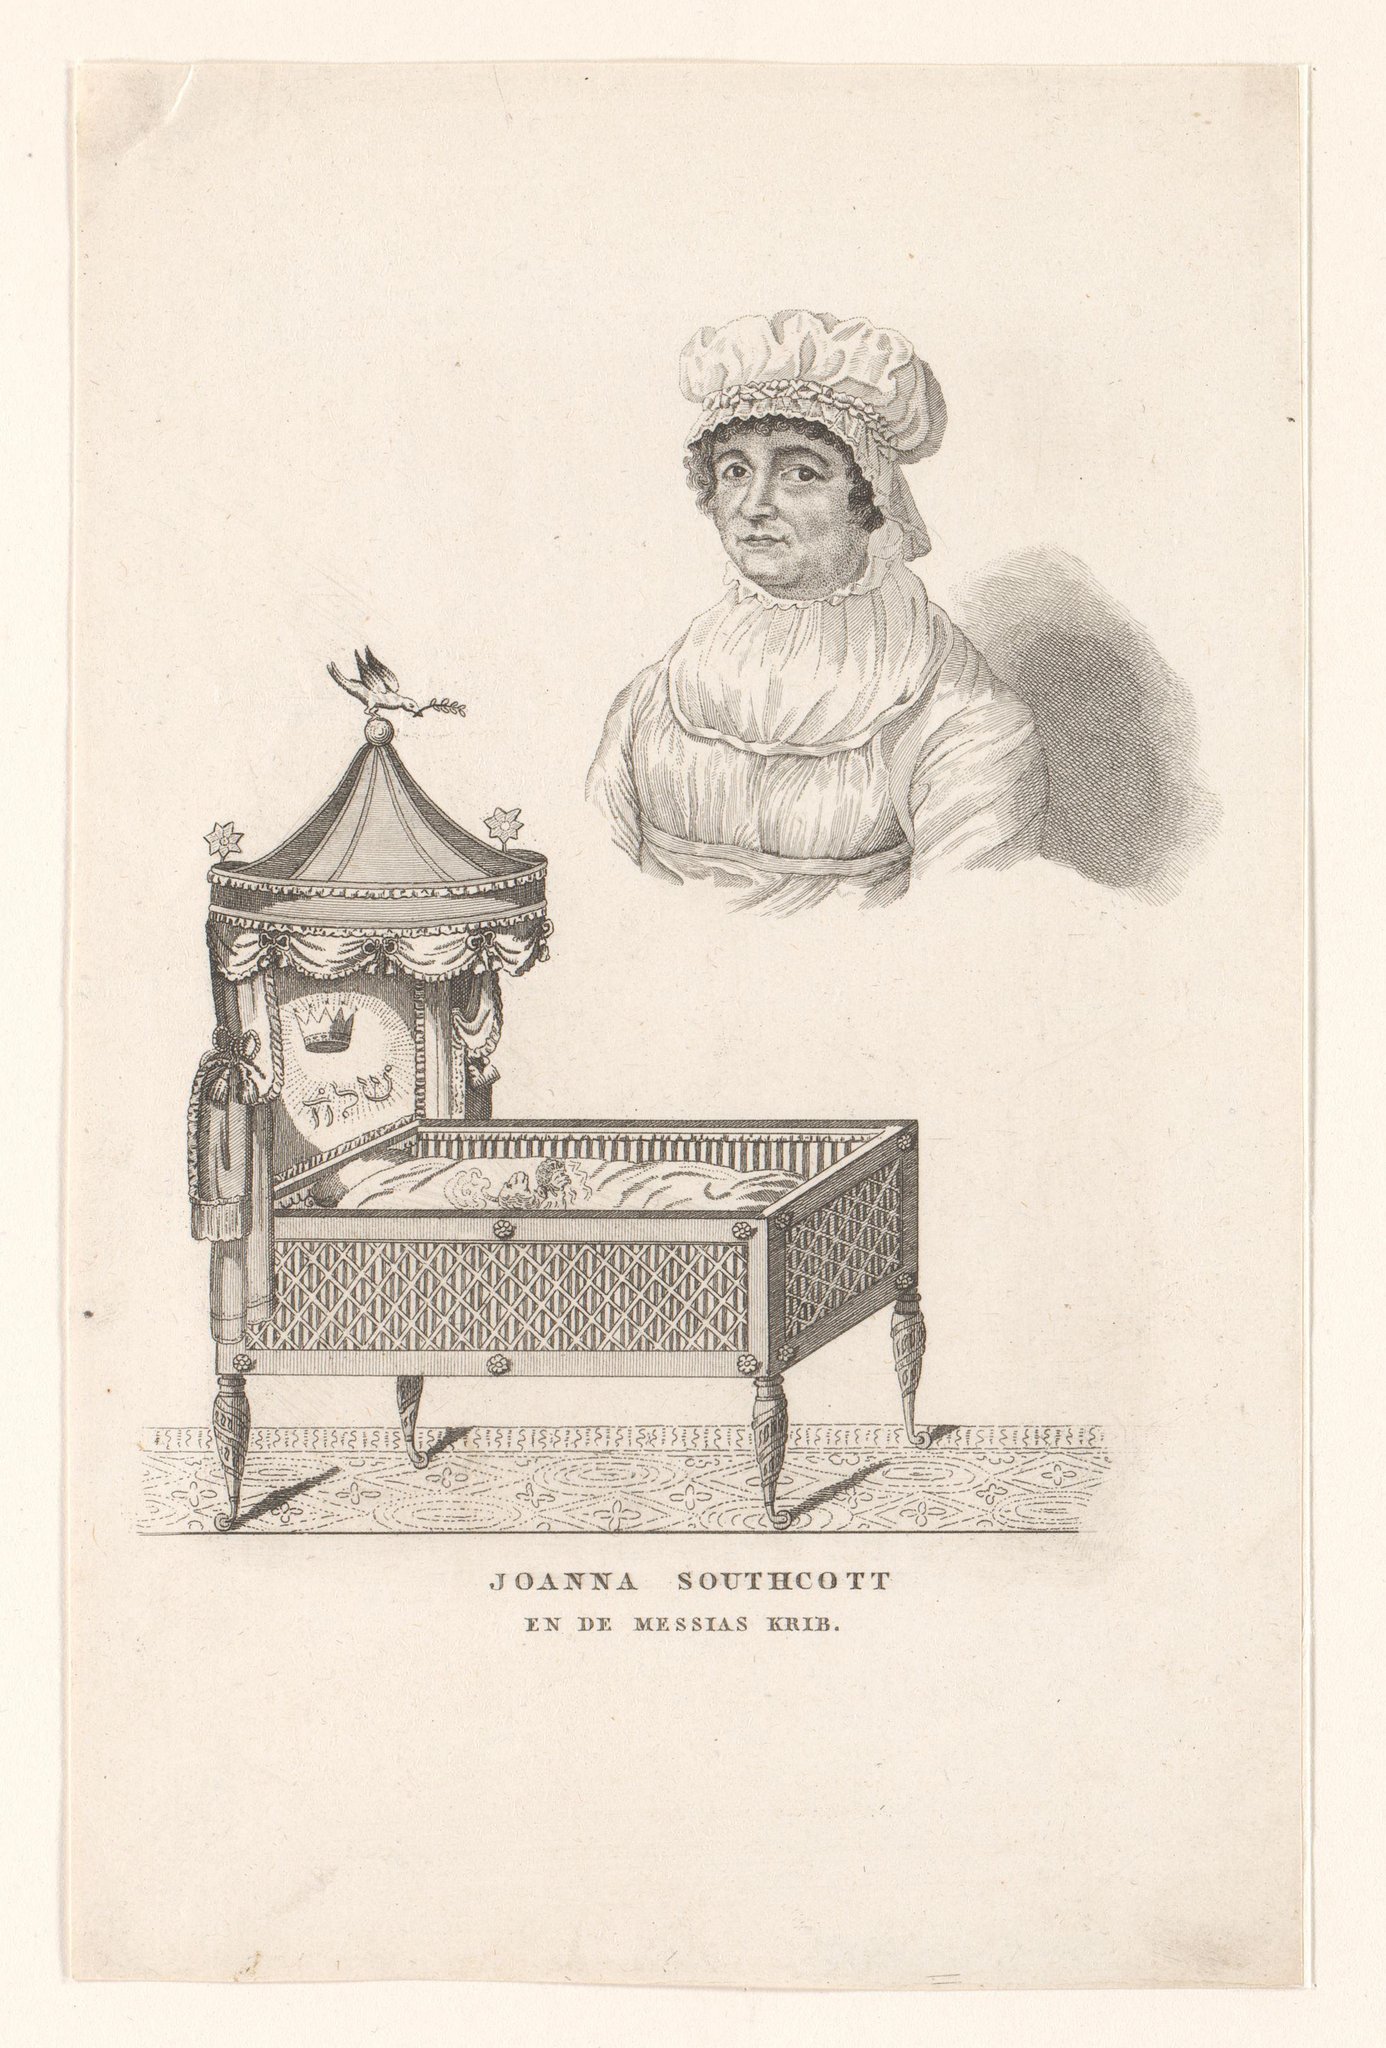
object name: print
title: Joanna Southcott en de messias krib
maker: Anonymous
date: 1822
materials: paper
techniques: etching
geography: netherlands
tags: historical persons - bb - woman, cradle, crib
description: Southcott beweerde dat zij zwanger was van de nieuwe messias, die 19 oktober 1814 geboren zou worden. Prent waarschijnlijk uit: Niemeyer, August Hermann. Waarnemingen op eene reize naar Engeland in 1819 (...). Haarlem: Adriaan Loosjes, 1822, dl. 2.